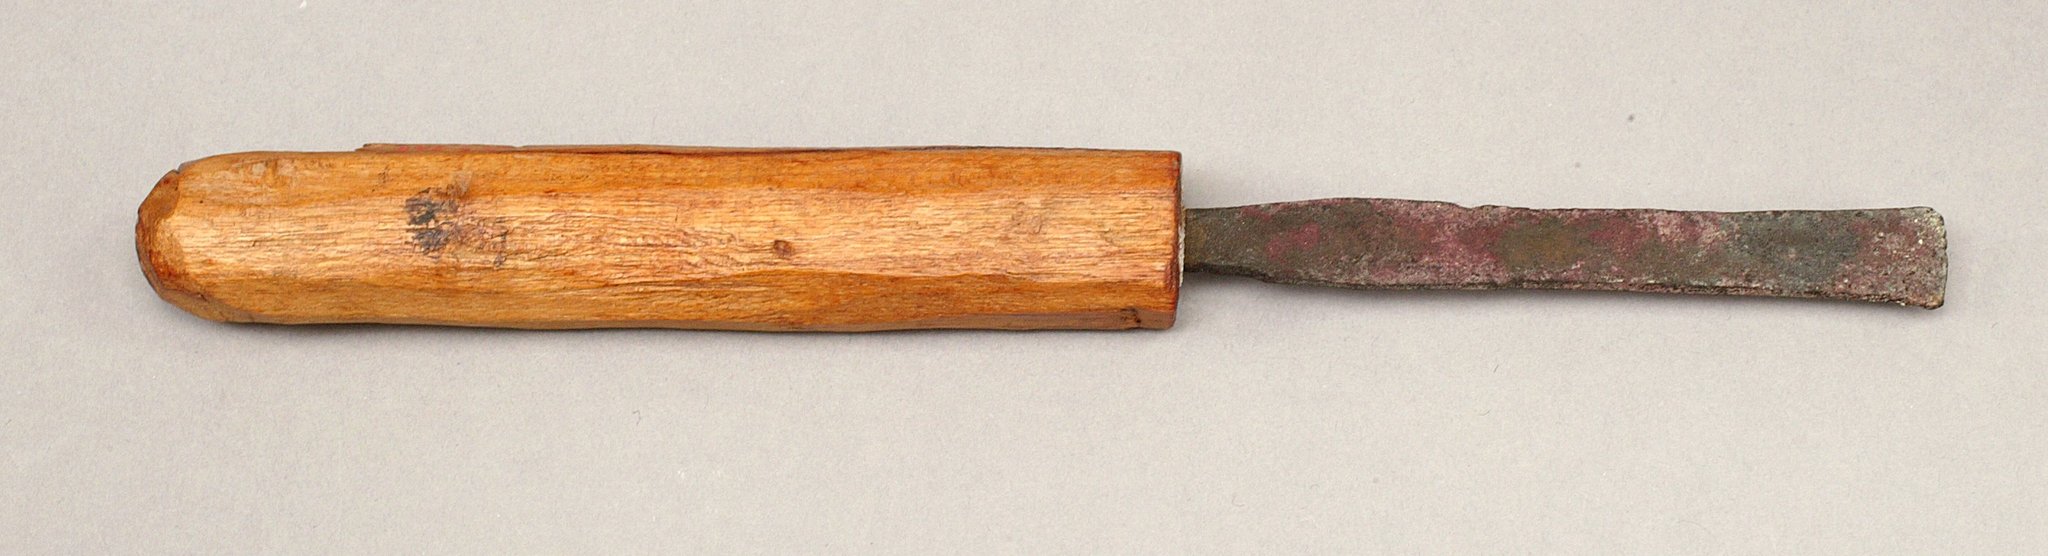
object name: chisel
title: Carpenter's Chisel from a Foundation Deposit for Hatshepsut's Temple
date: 1479-1458 BCE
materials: copper alloy, wood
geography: egypt